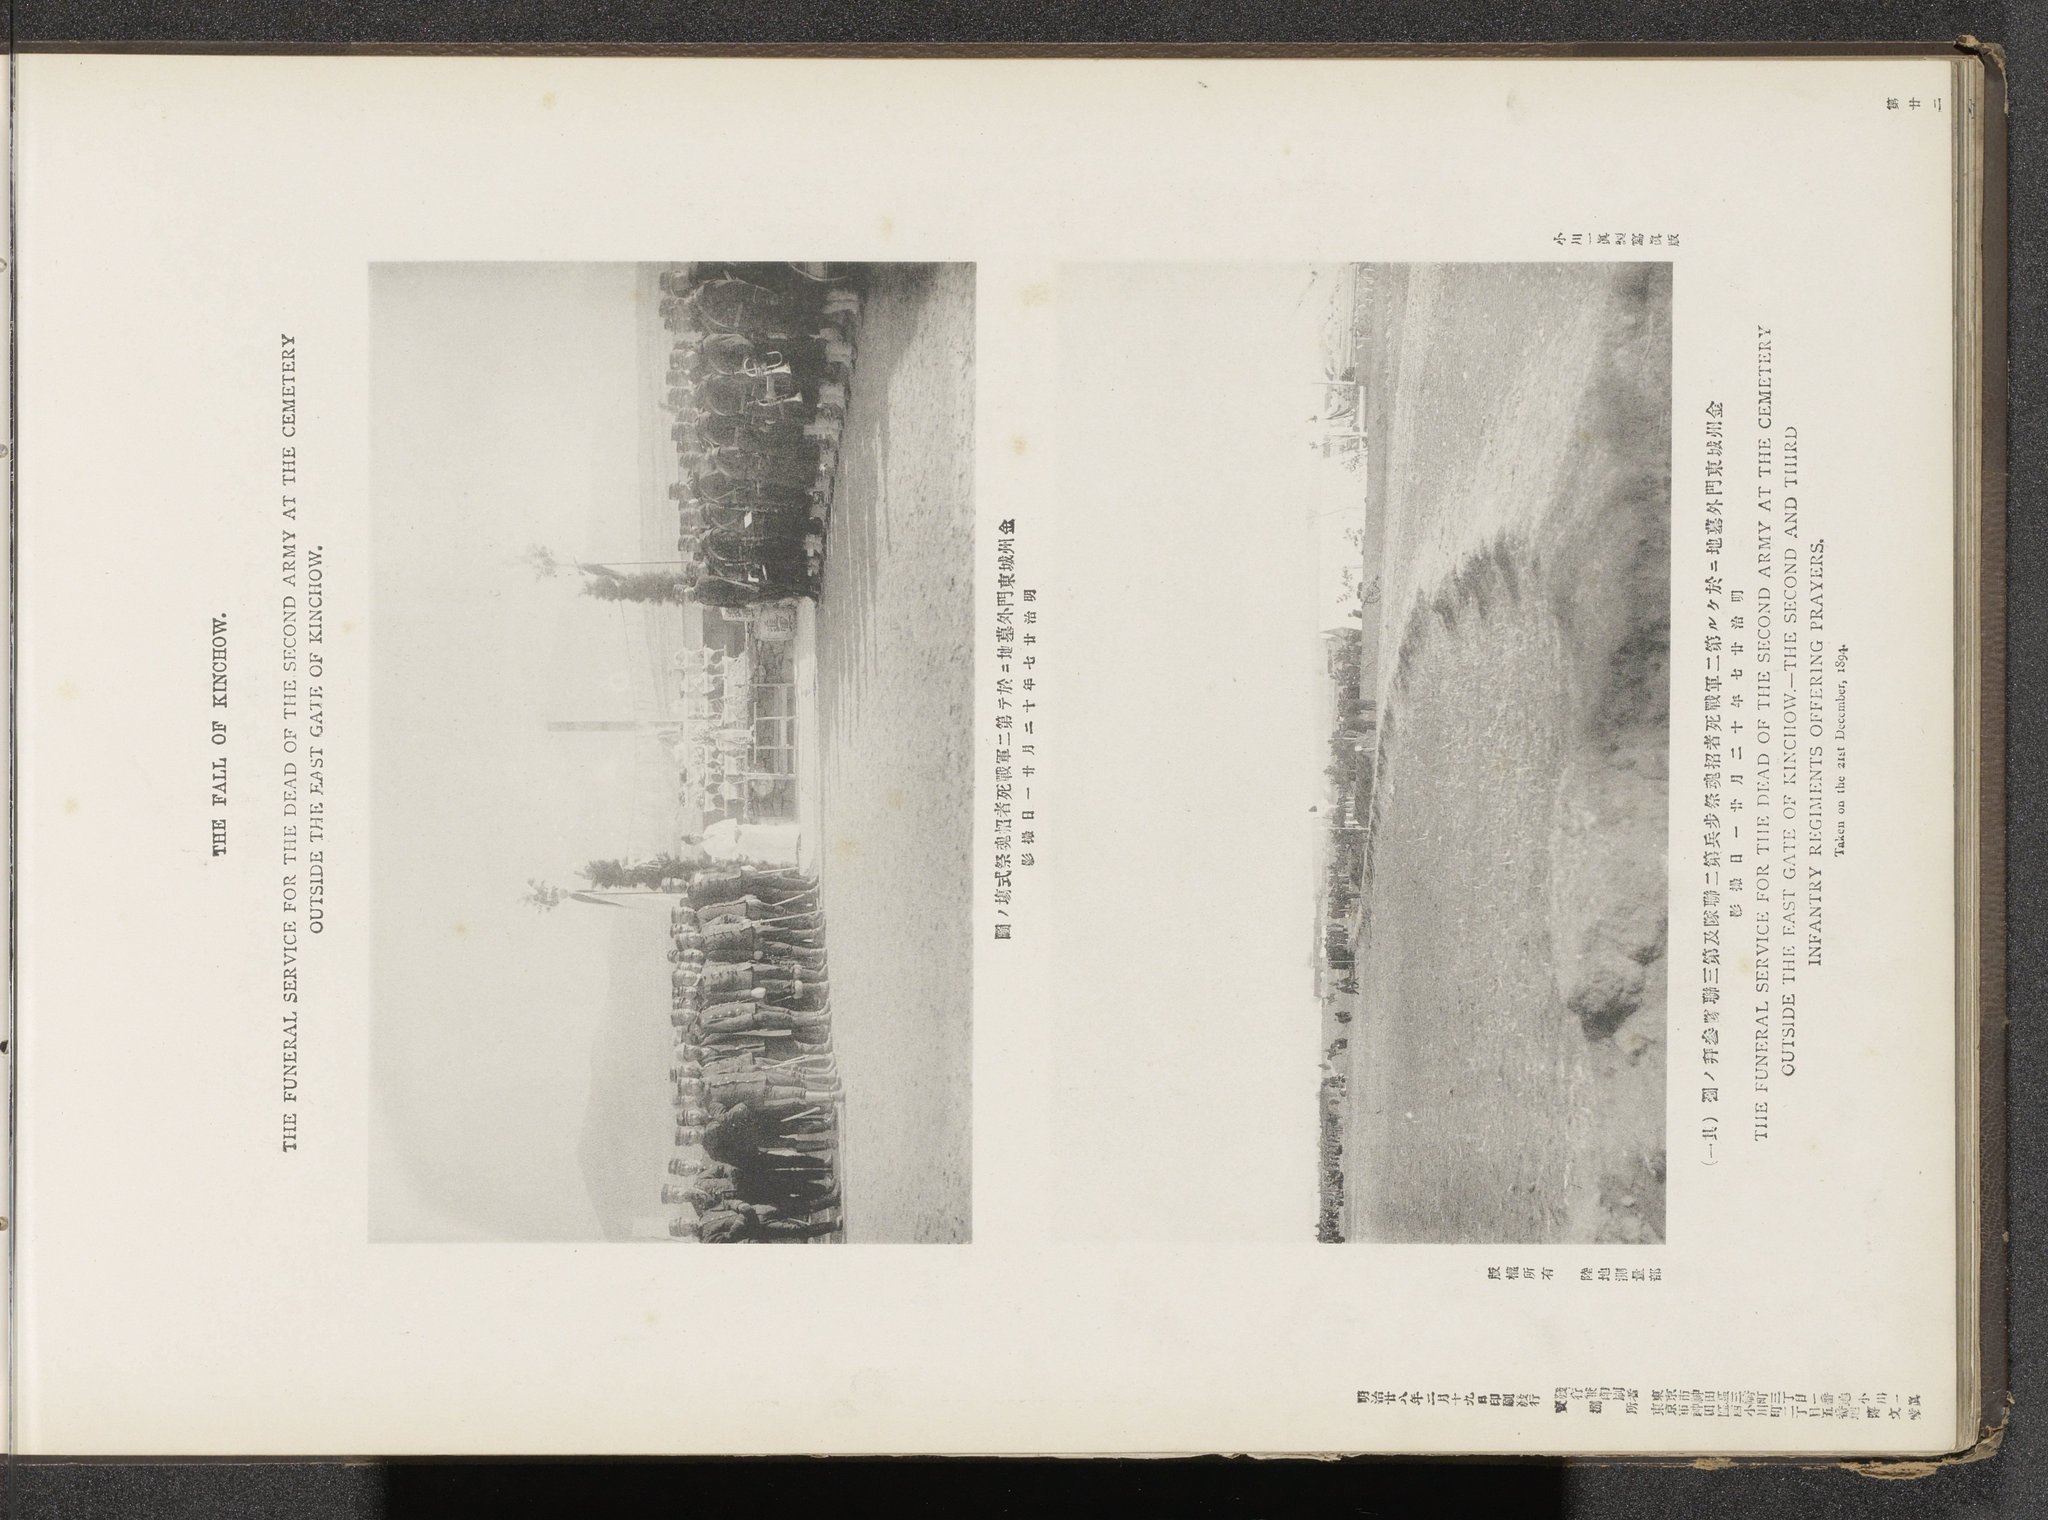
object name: page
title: Twee gezichten op een begrafenisceremonie voor de slachtoffers van het Japanse leger op de begraafplaats te Chinchow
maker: kazumasa ogawa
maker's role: auteur, fotograaf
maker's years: 1860-1929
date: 1894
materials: paper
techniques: photograph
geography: chinchow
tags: priest ~ shinto, funerary ceremonial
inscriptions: inscription: ‘The fall of Kinchow.’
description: Boven een gezicht op het altaar met daarnaast een shintopriester, onder een gezicht op de ceremonie.